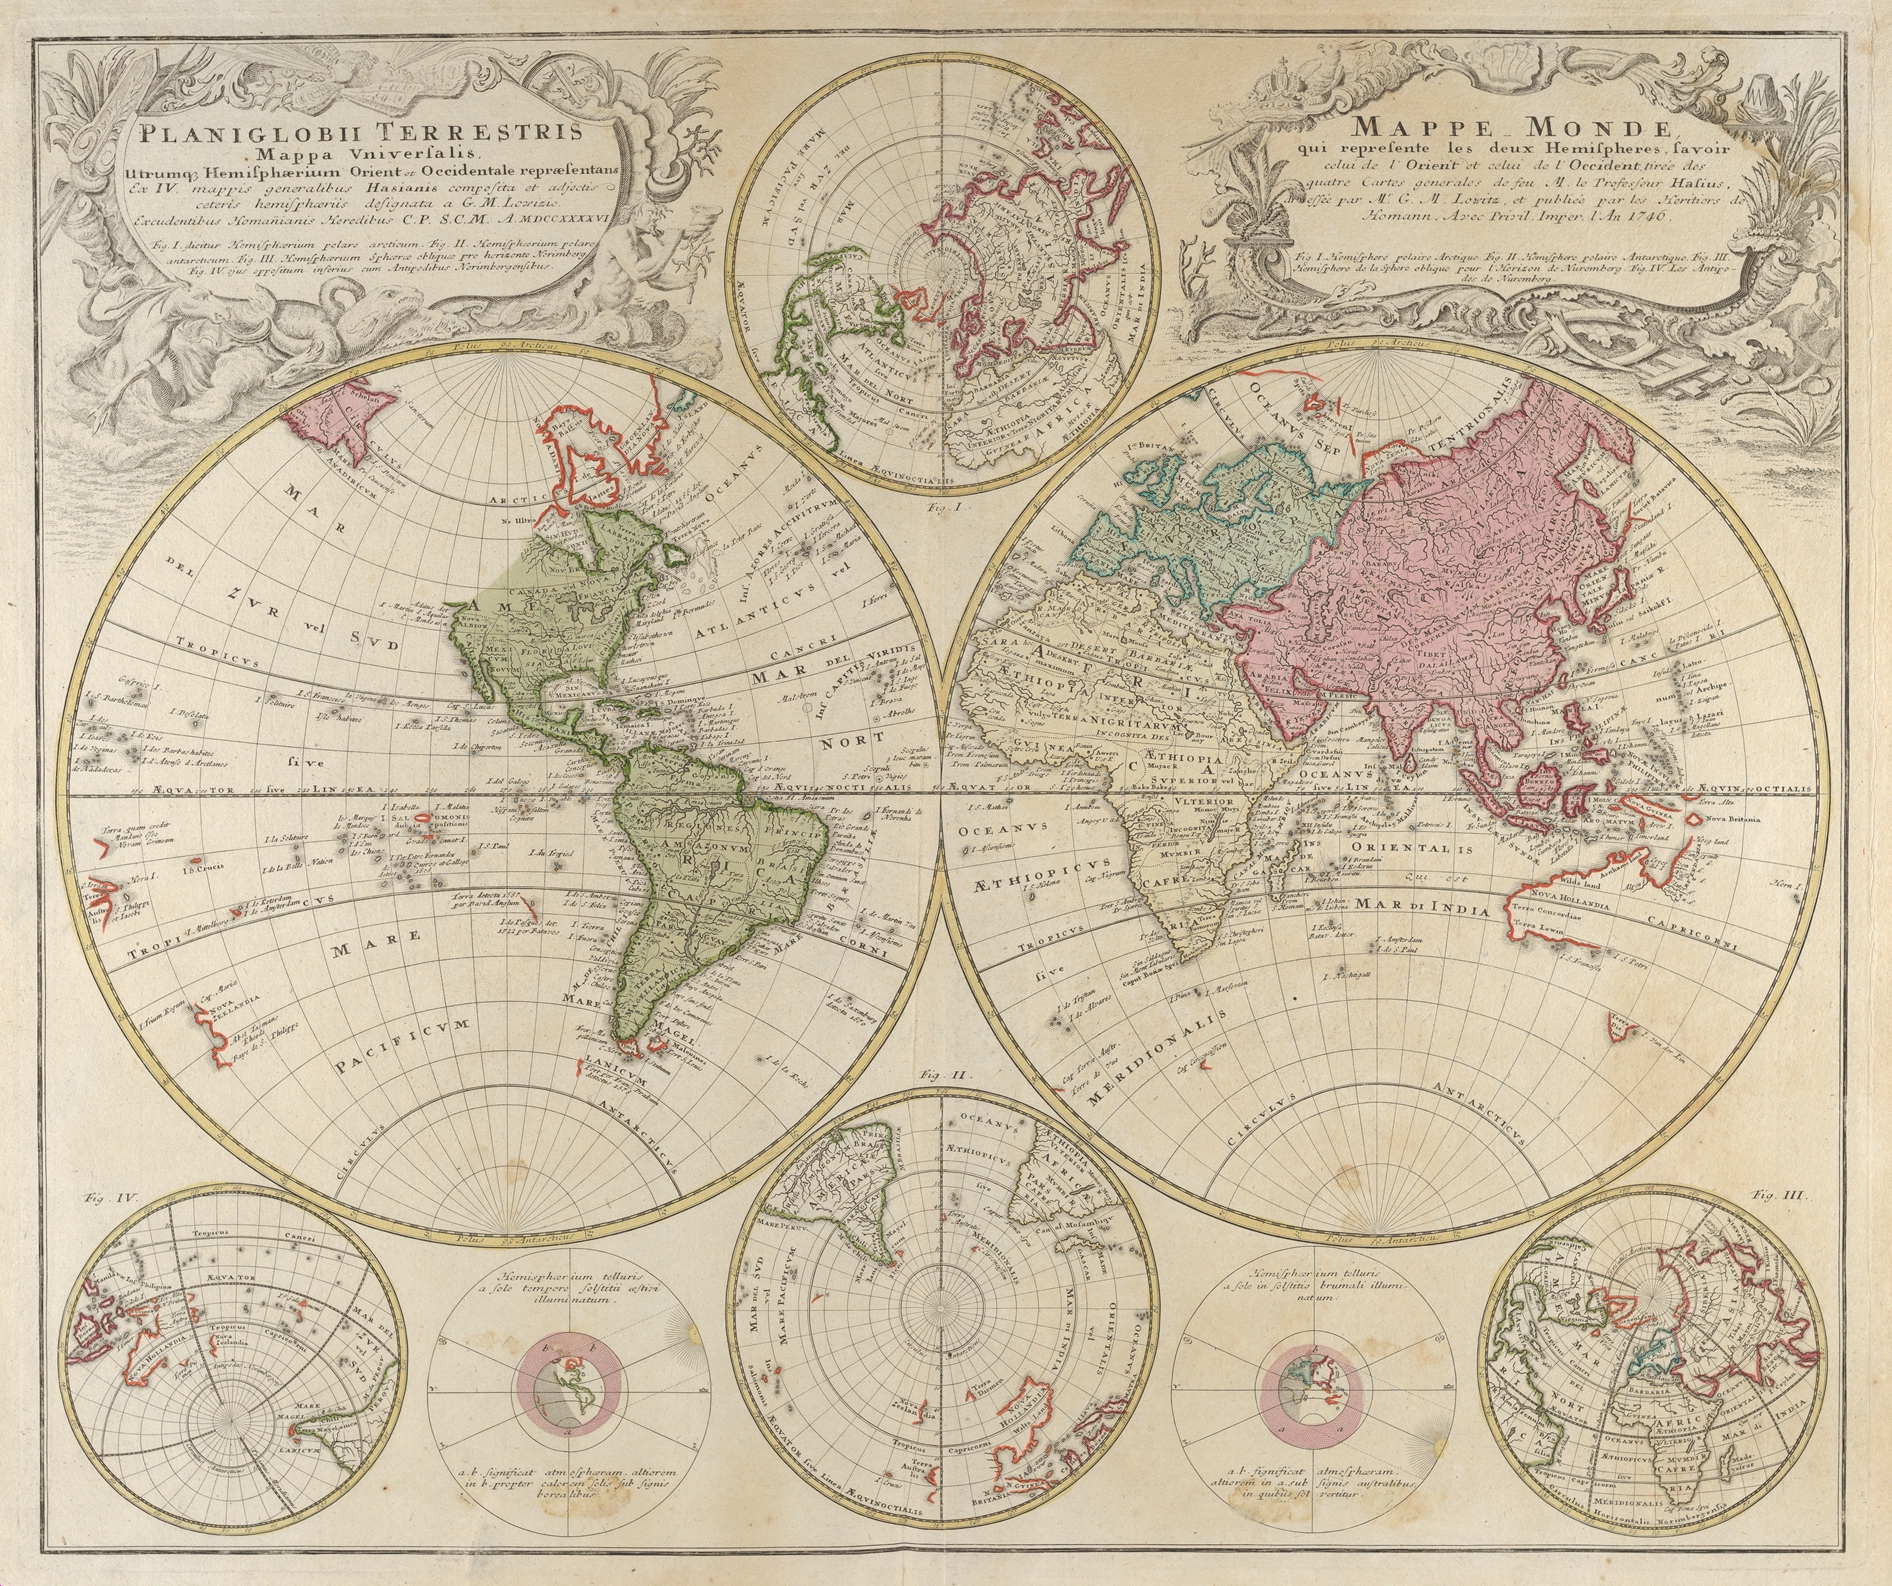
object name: print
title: Planiglobii Terrestris Mappa Universalis...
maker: johann baptist homann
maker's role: artist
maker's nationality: german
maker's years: 1664-1724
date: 1746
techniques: engraving, hand coloring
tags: maps